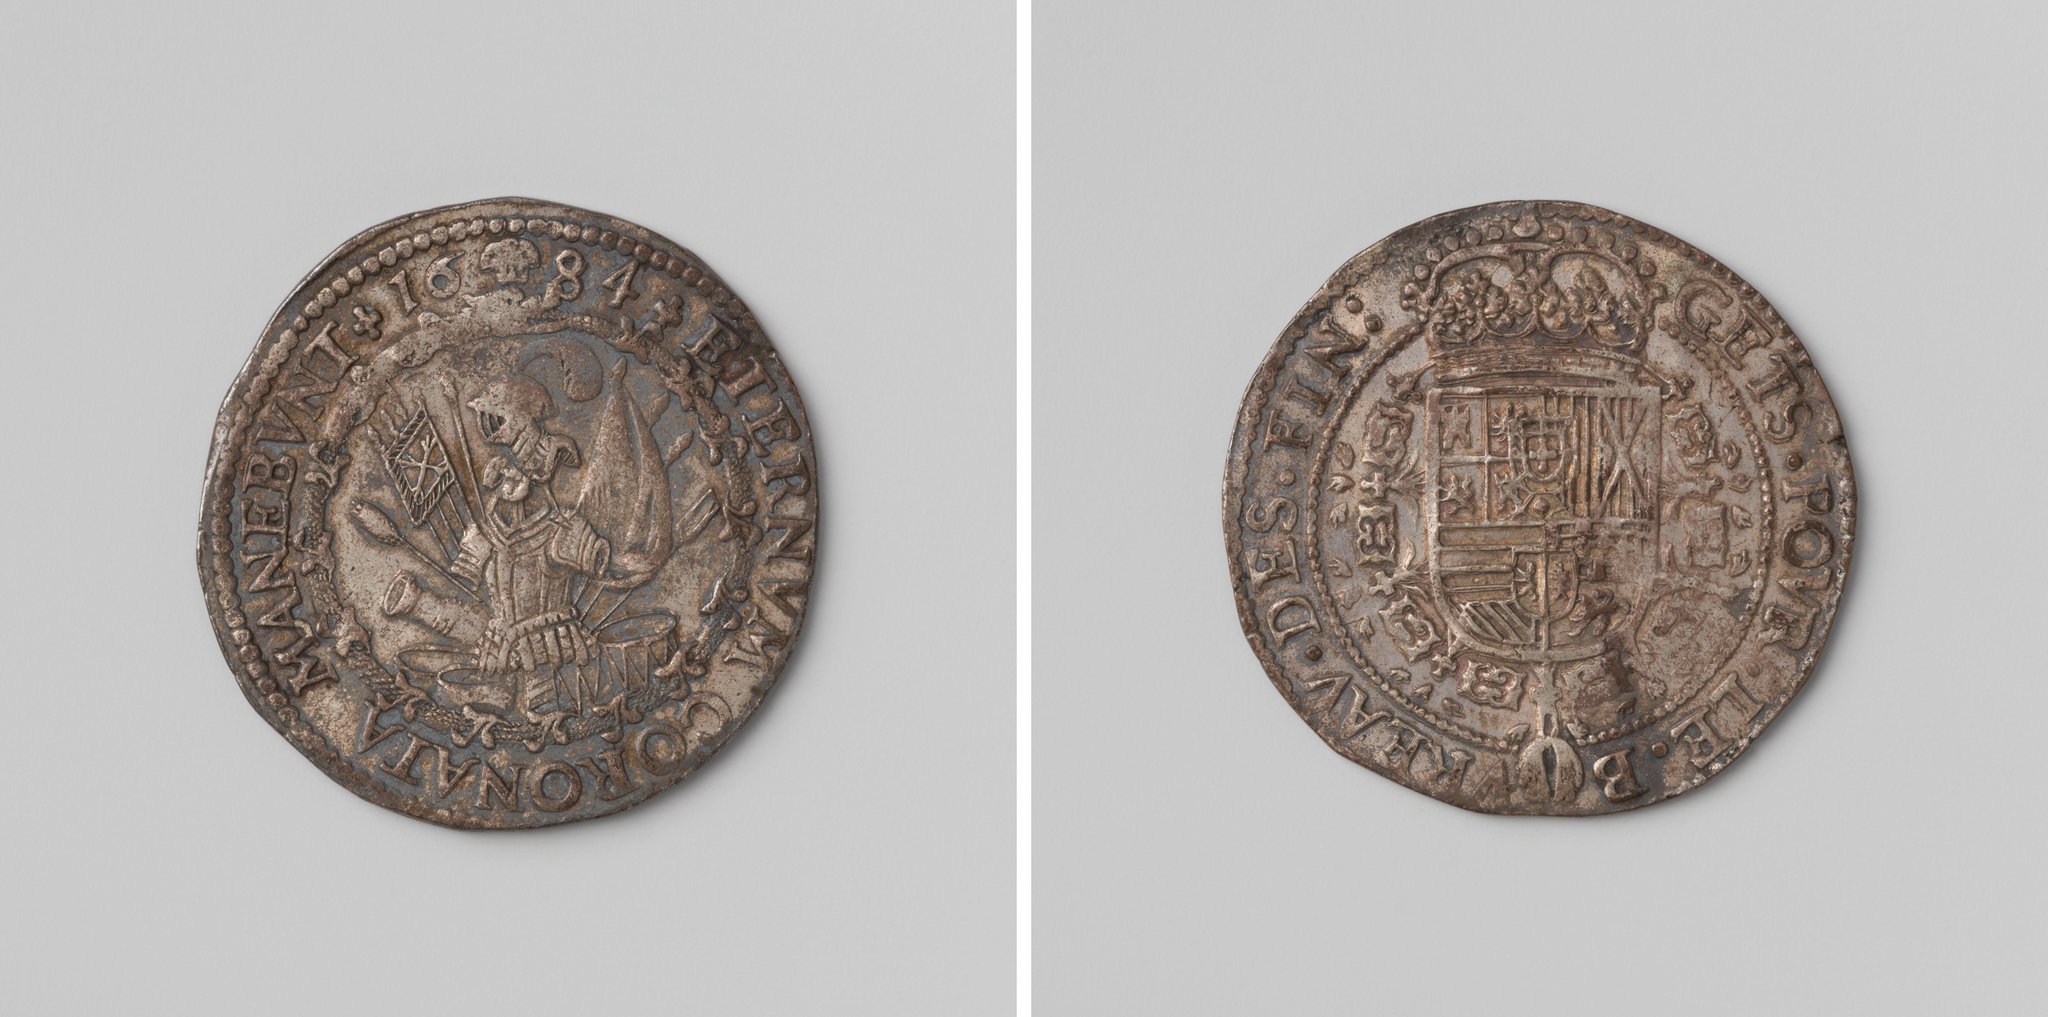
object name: jeton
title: Twintigjarige bestand van Regensburg tussen Frankrijk, de Keizer, Spanje en de Nederlanden, rekenpenning geslagen op last van de raad van Financien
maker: Anonymous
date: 1684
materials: silver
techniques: striking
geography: brussels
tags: regensburg, bestand van regensburg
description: Zilveren penning. Voorzijde: wapentrophee binnen slangerond en omschrift. Keerzijde: gekroond wapenschild, omhangen met de orde van het Gulden Vlies binnen omschrift